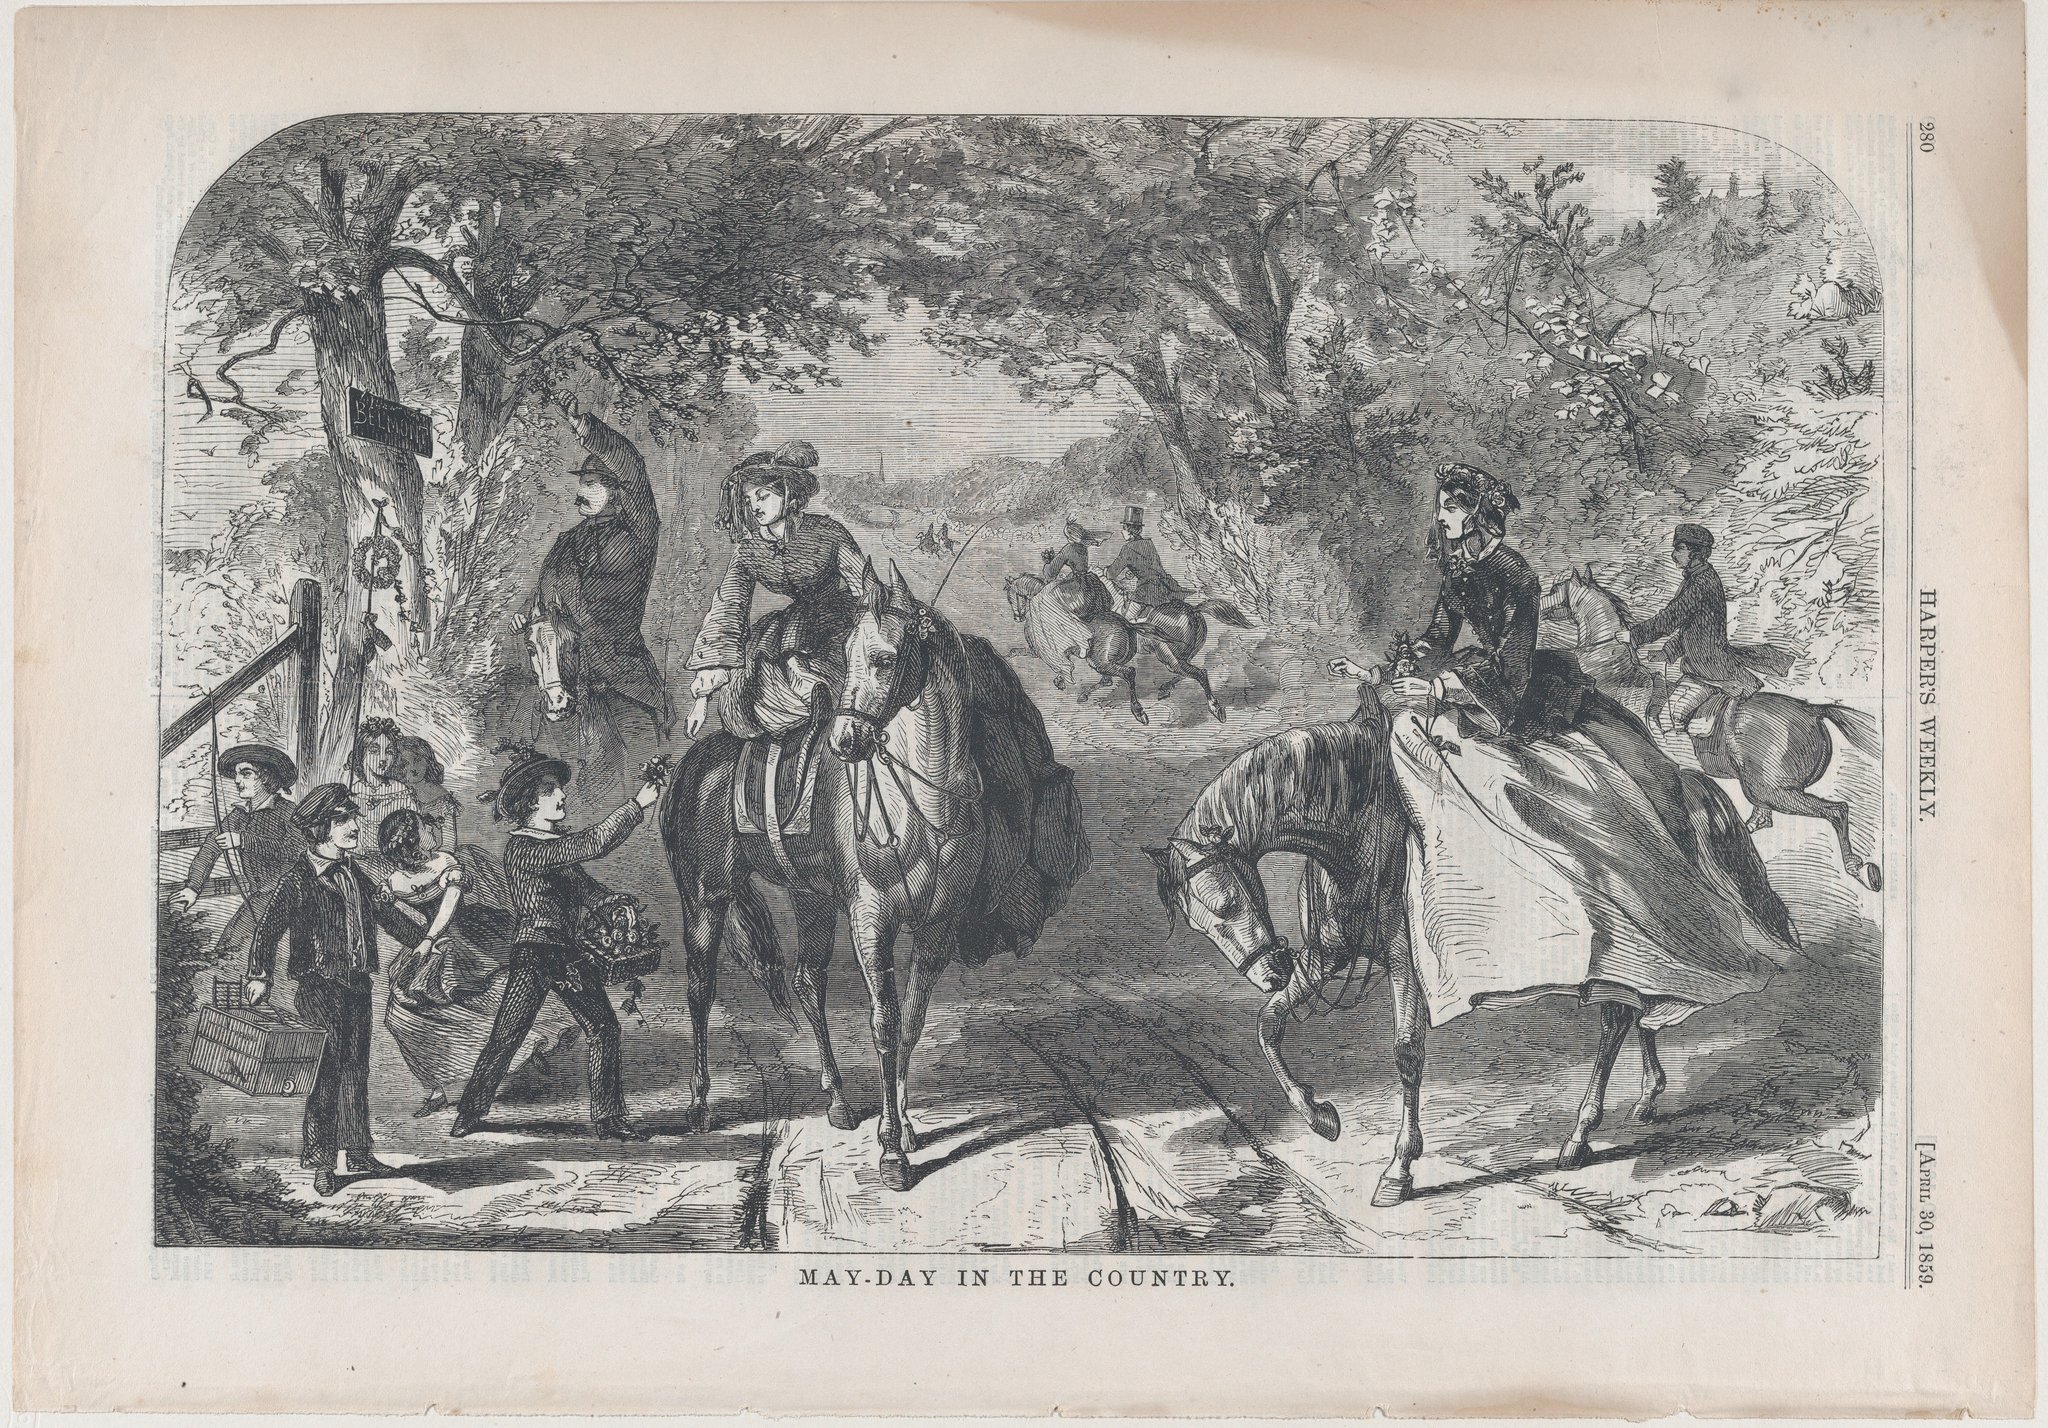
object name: print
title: May-Day in the Country (from "Harper's Weekly," Vol. III)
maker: winslow homer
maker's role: artist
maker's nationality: american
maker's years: 1836-1910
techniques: engraving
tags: children,men,women,horses